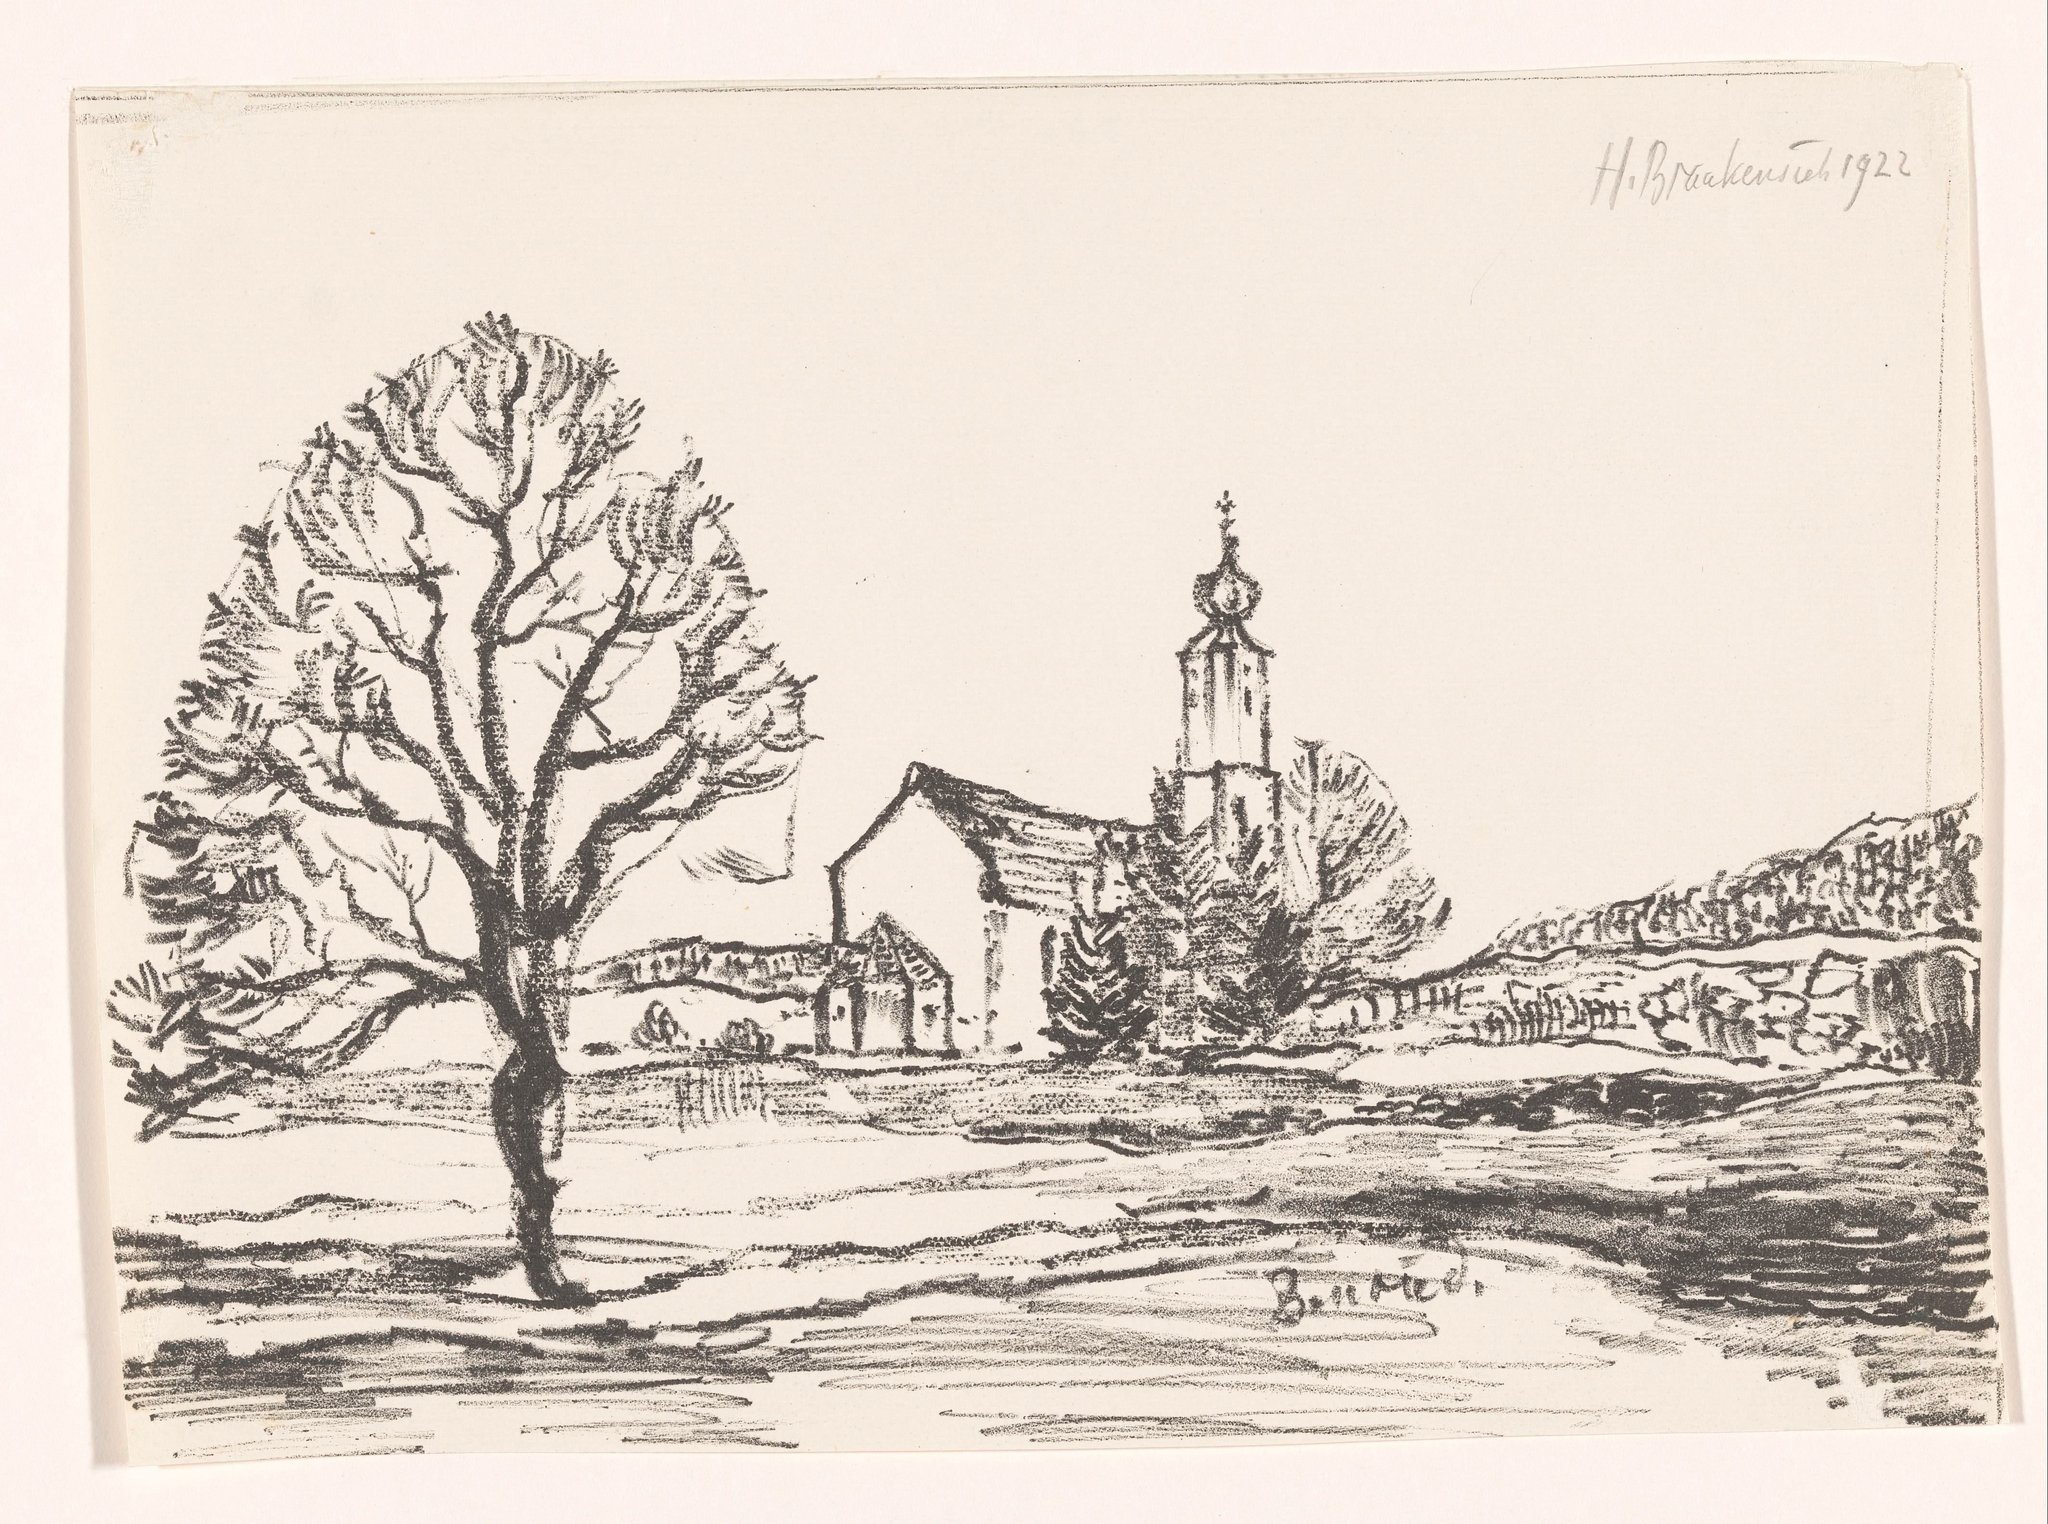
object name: print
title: Bernried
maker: henri braakensiek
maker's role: print maker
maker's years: 1891-1941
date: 1922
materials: paper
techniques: lithograph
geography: munich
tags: low hill country, church (exterior) - qq - small church, chapel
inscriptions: collector's mark: Lugt 2228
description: Een kerk met apsis in een landschap met meerdere heuvels. Links op de voorgrond een boom.